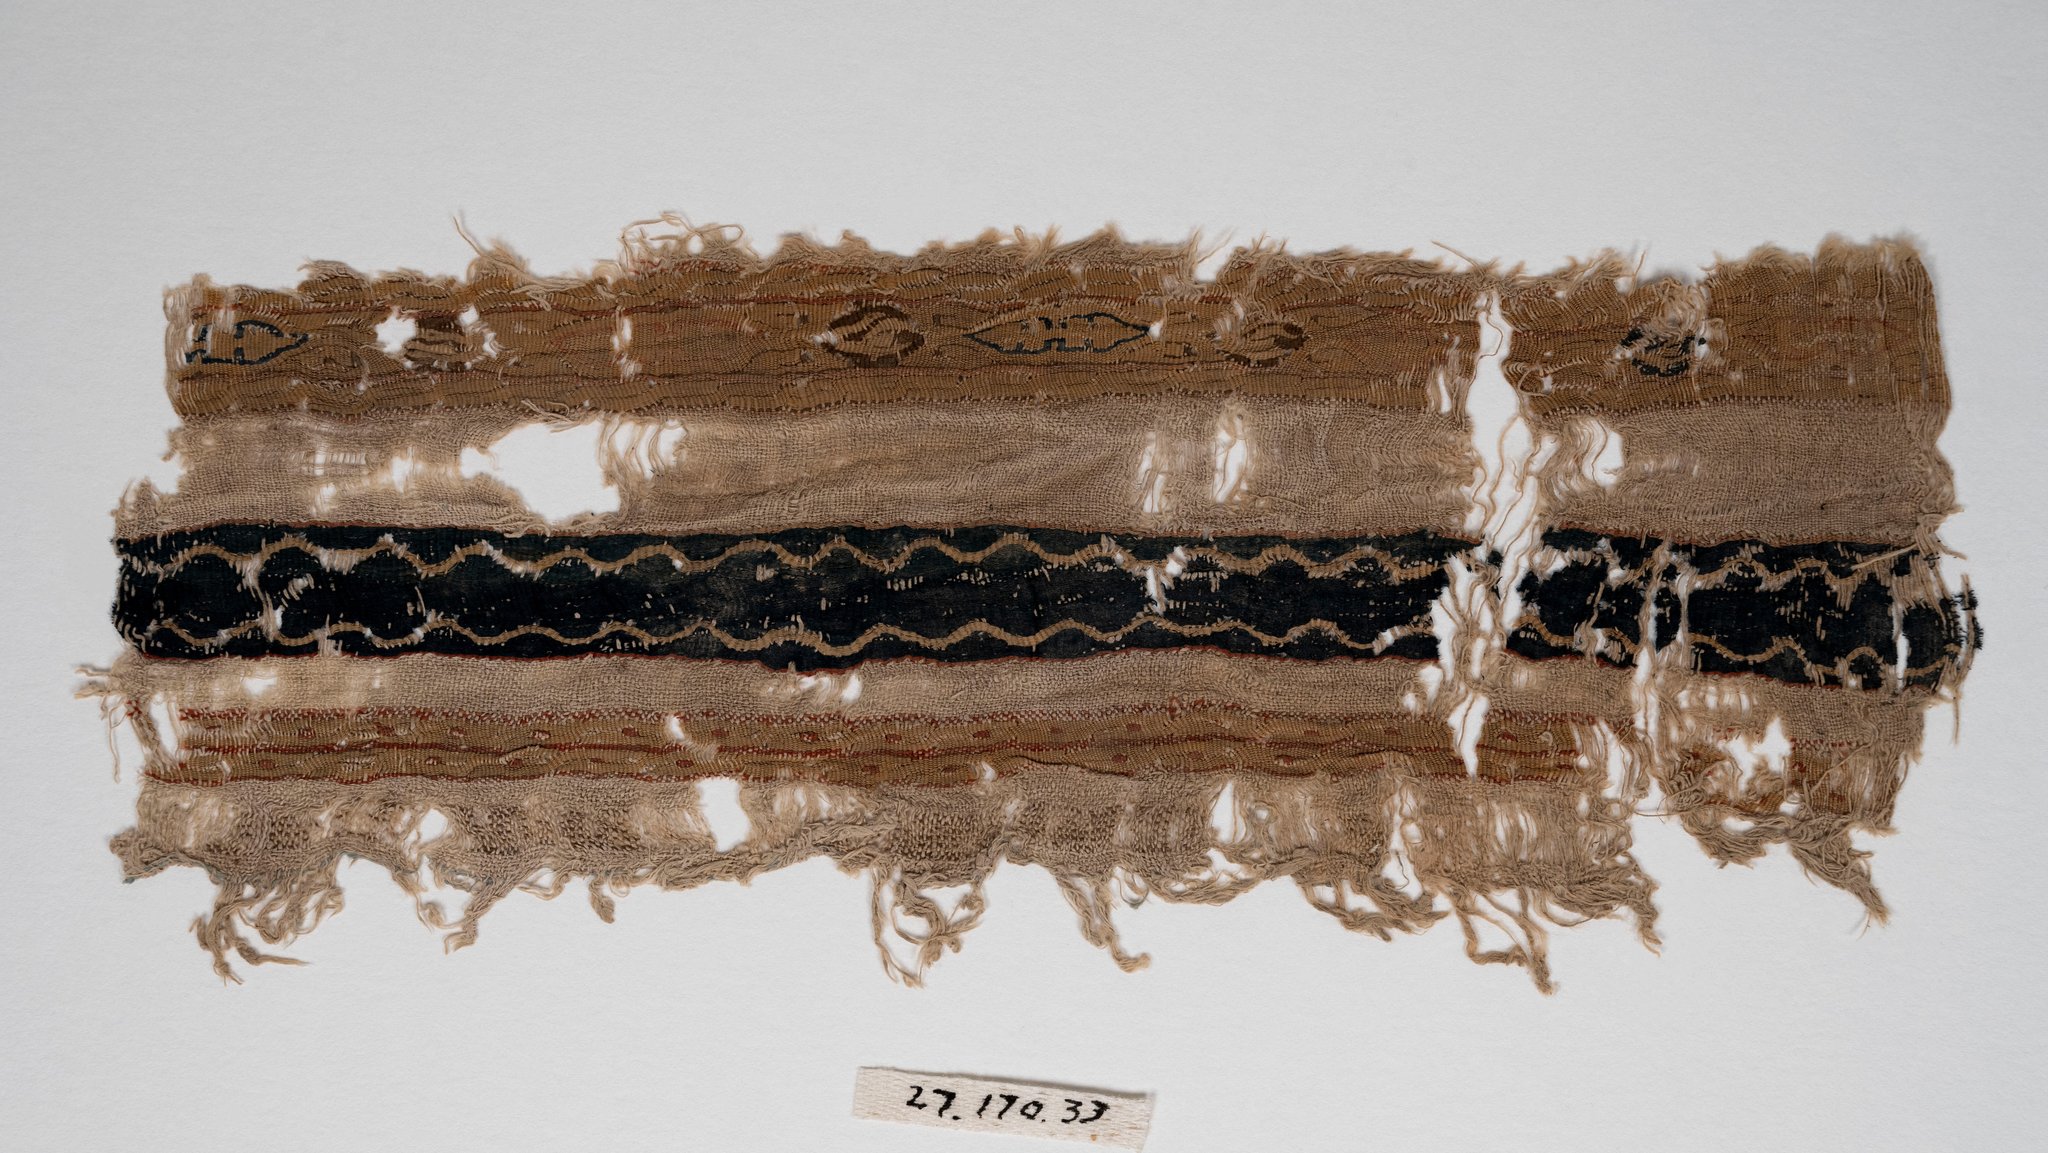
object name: textile fragment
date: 1101-1200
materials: cotton, silk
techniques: tapestry, weave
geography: egypt